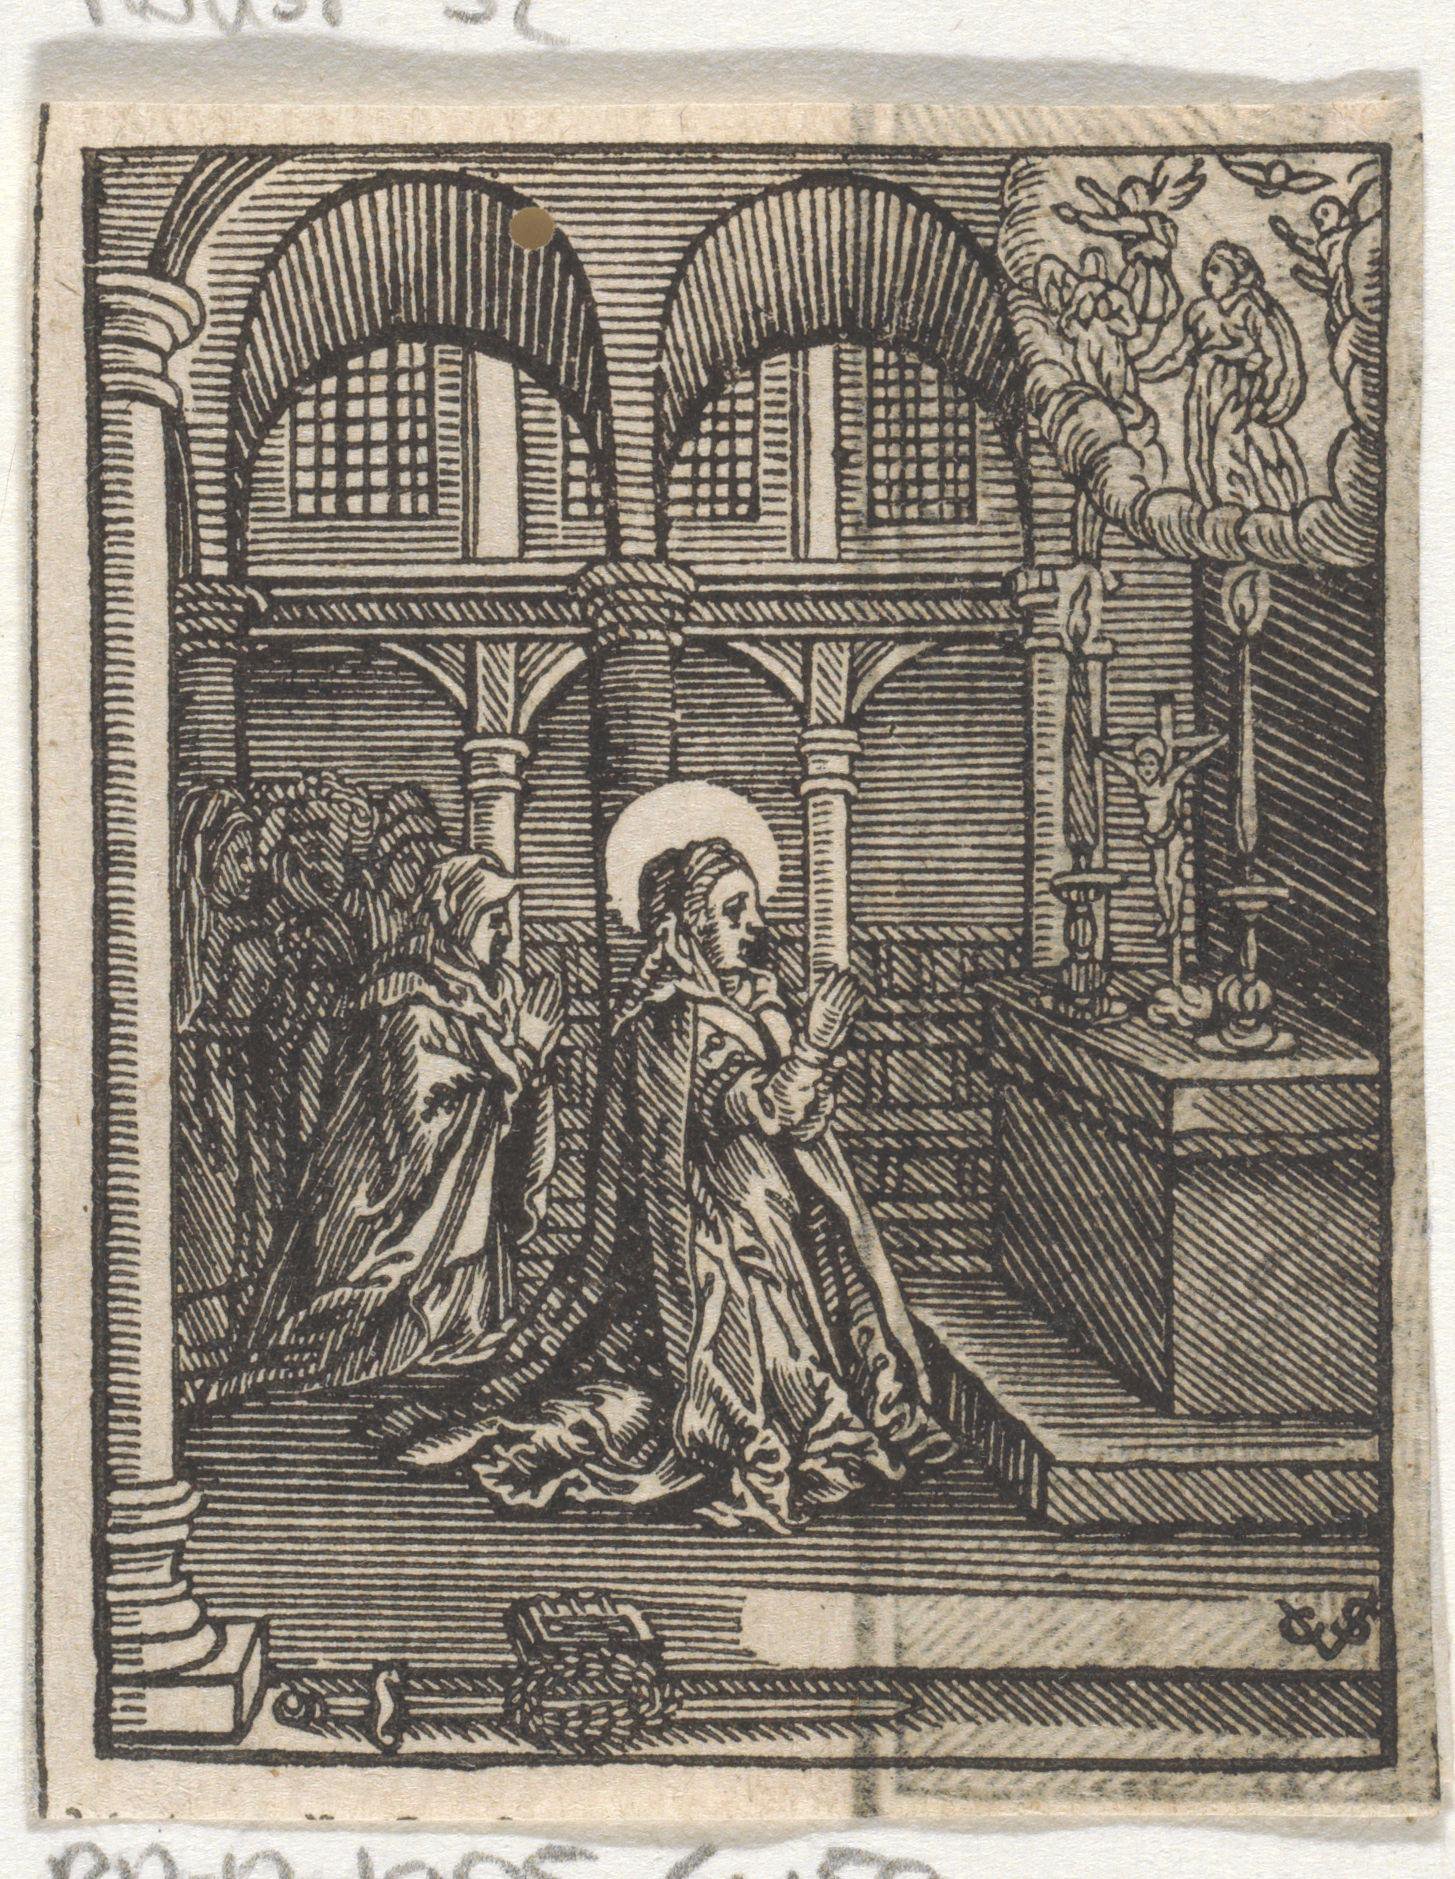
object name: book illustration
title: Heilige knielend voor een crucifix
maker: christoffel van sichem (ii)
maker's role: print maker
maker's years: 1581-1658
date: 1581-1658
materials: paper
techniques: woodcut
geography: amsterdam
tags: altarcross, crucifix, female saints